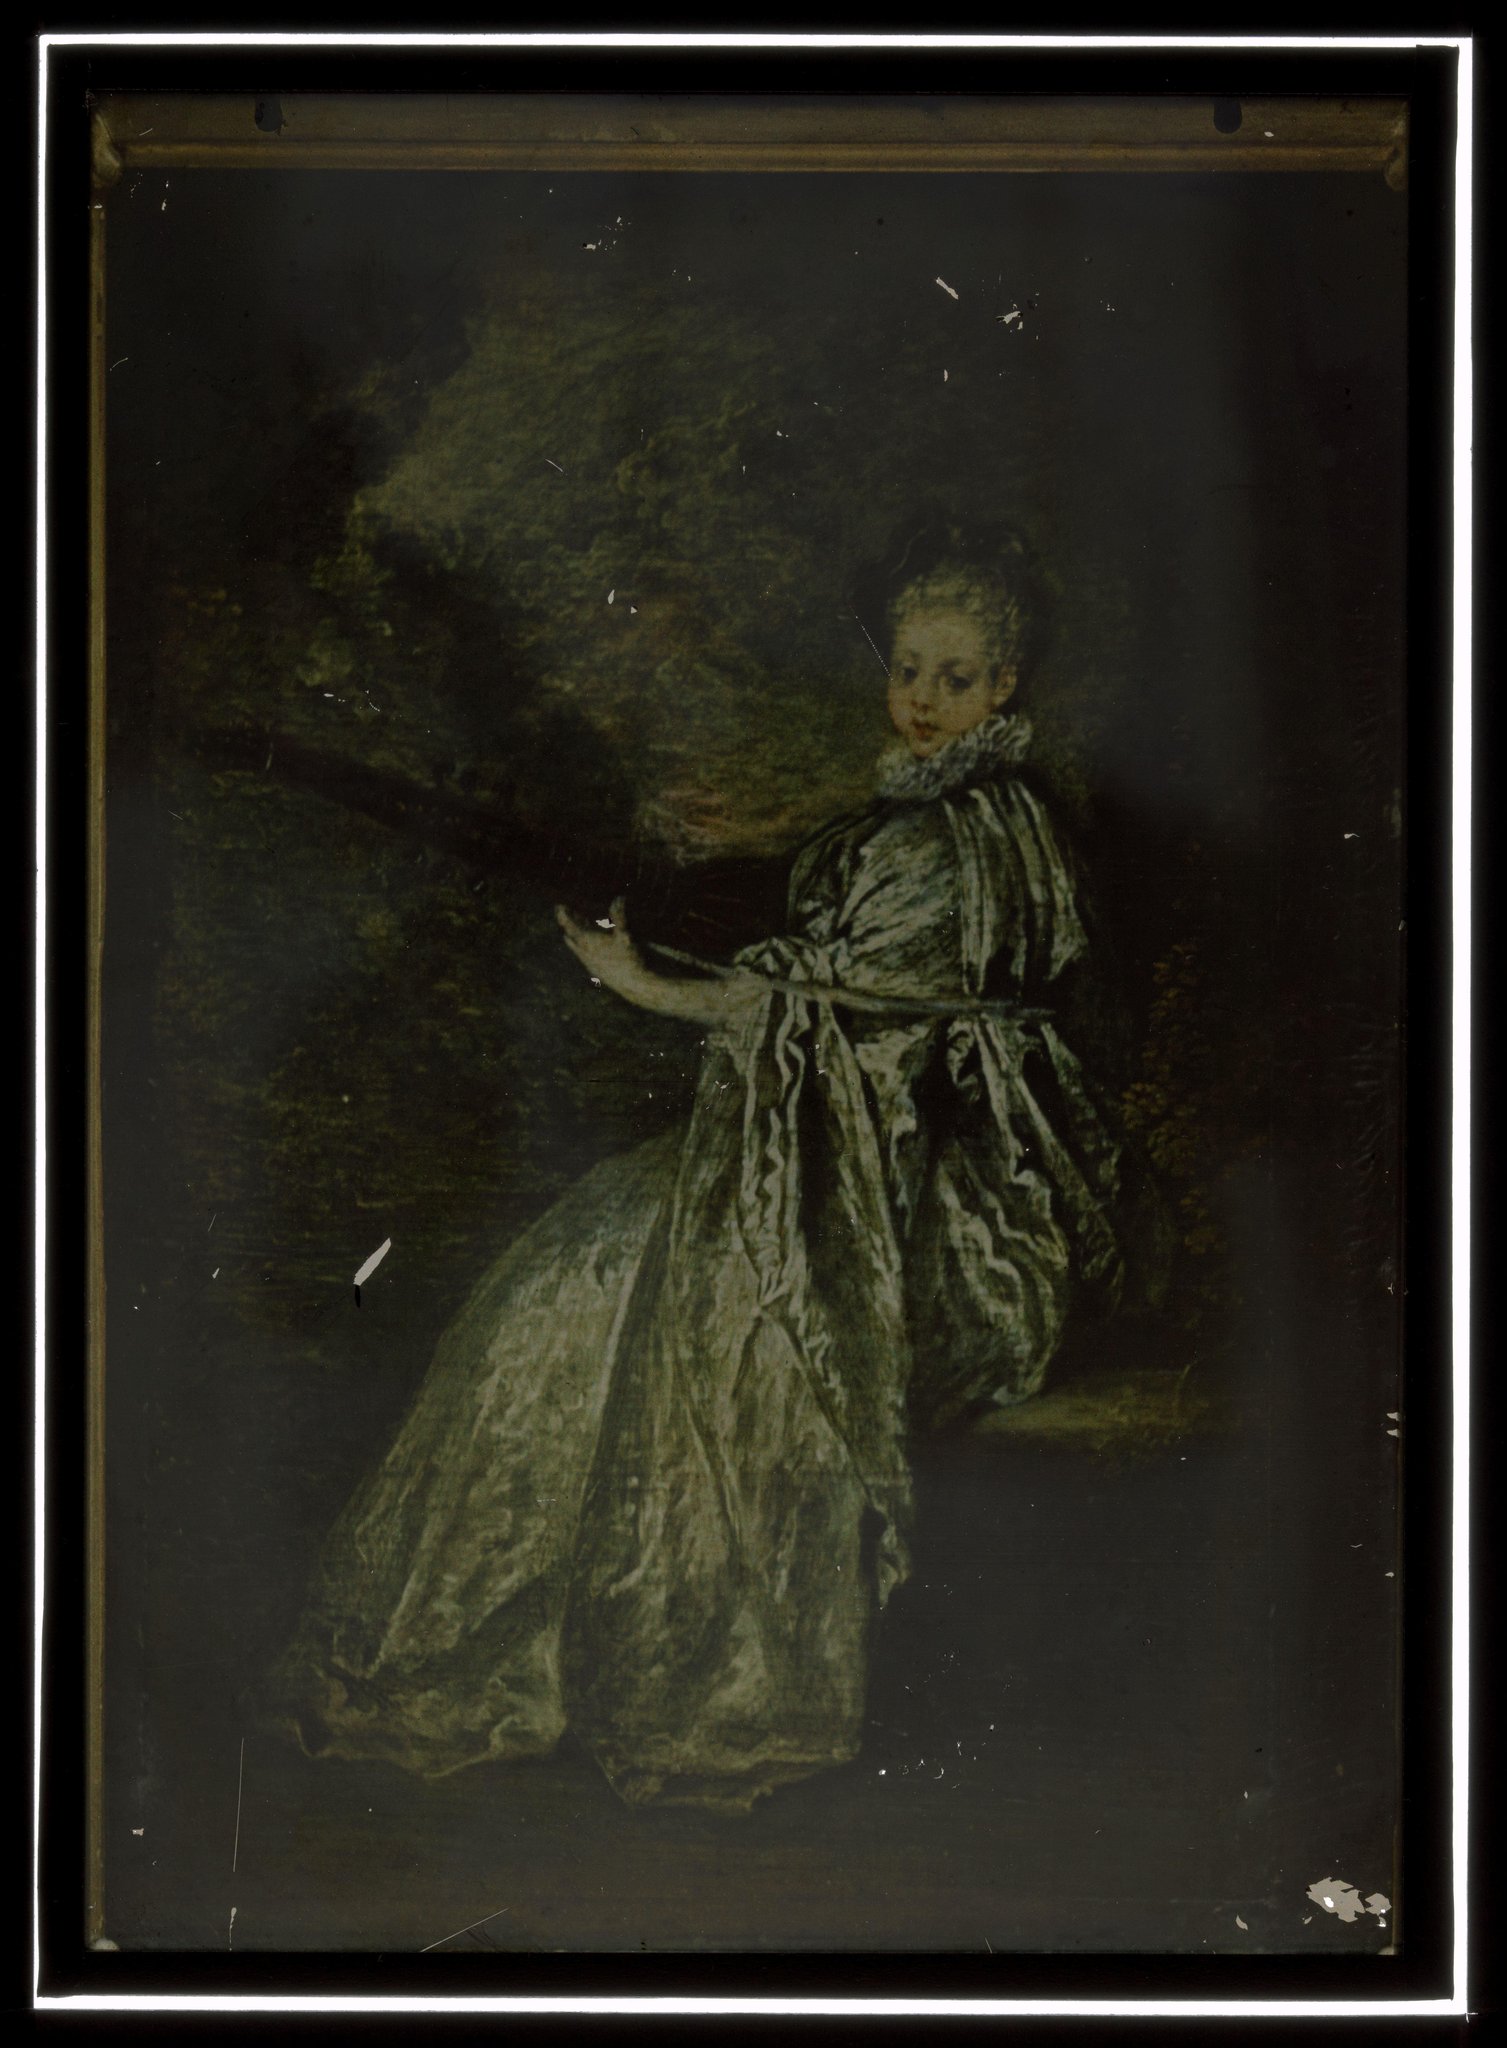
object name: photograph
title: Reproductie van Antoine Watteau, La Finette, Louvre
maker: Anonymous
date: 1907-1935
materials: glass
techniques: autochrome process, slide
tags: picture, painting